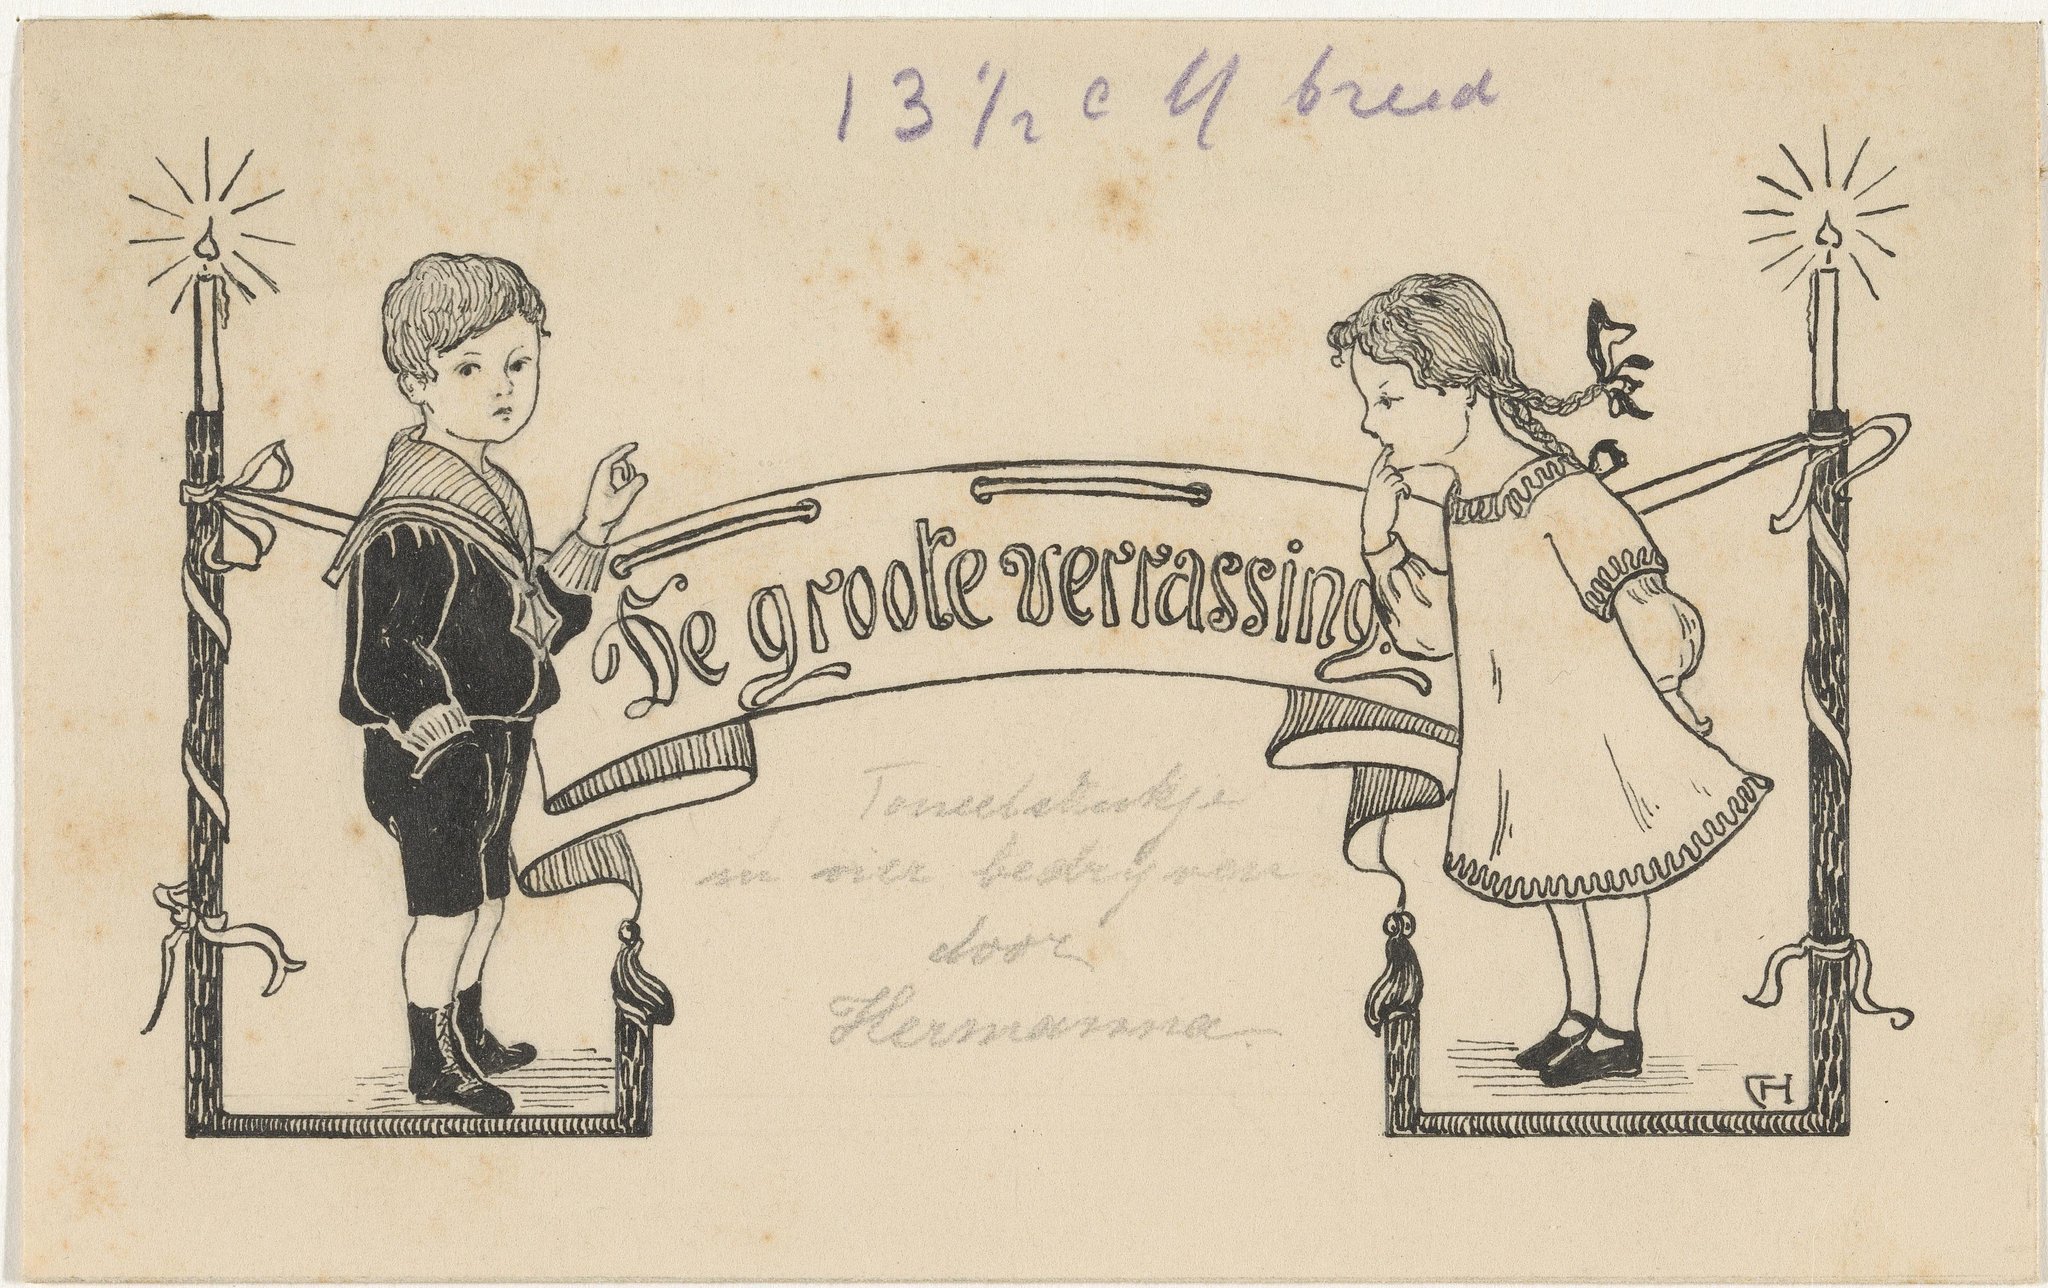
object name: boekillustratie ontwerp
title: De groote verrassing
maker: Anonymous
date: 1890-1940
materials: ink, paper, pencil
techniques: pen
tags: banderole, candlestick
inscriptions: annotation: ‘Toneelstukje/ in vier bedrijven/ door Hermanna’, signature: ‘CH’, collector's mark: Lugt 2228a, :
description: Een jongen en meisje staan aan weerszijden van een banier met daarop de tekst 'De groote verrassing'. De banier is met linten tussen twee hoge kandelaars met brandende kaarsen gespannen.